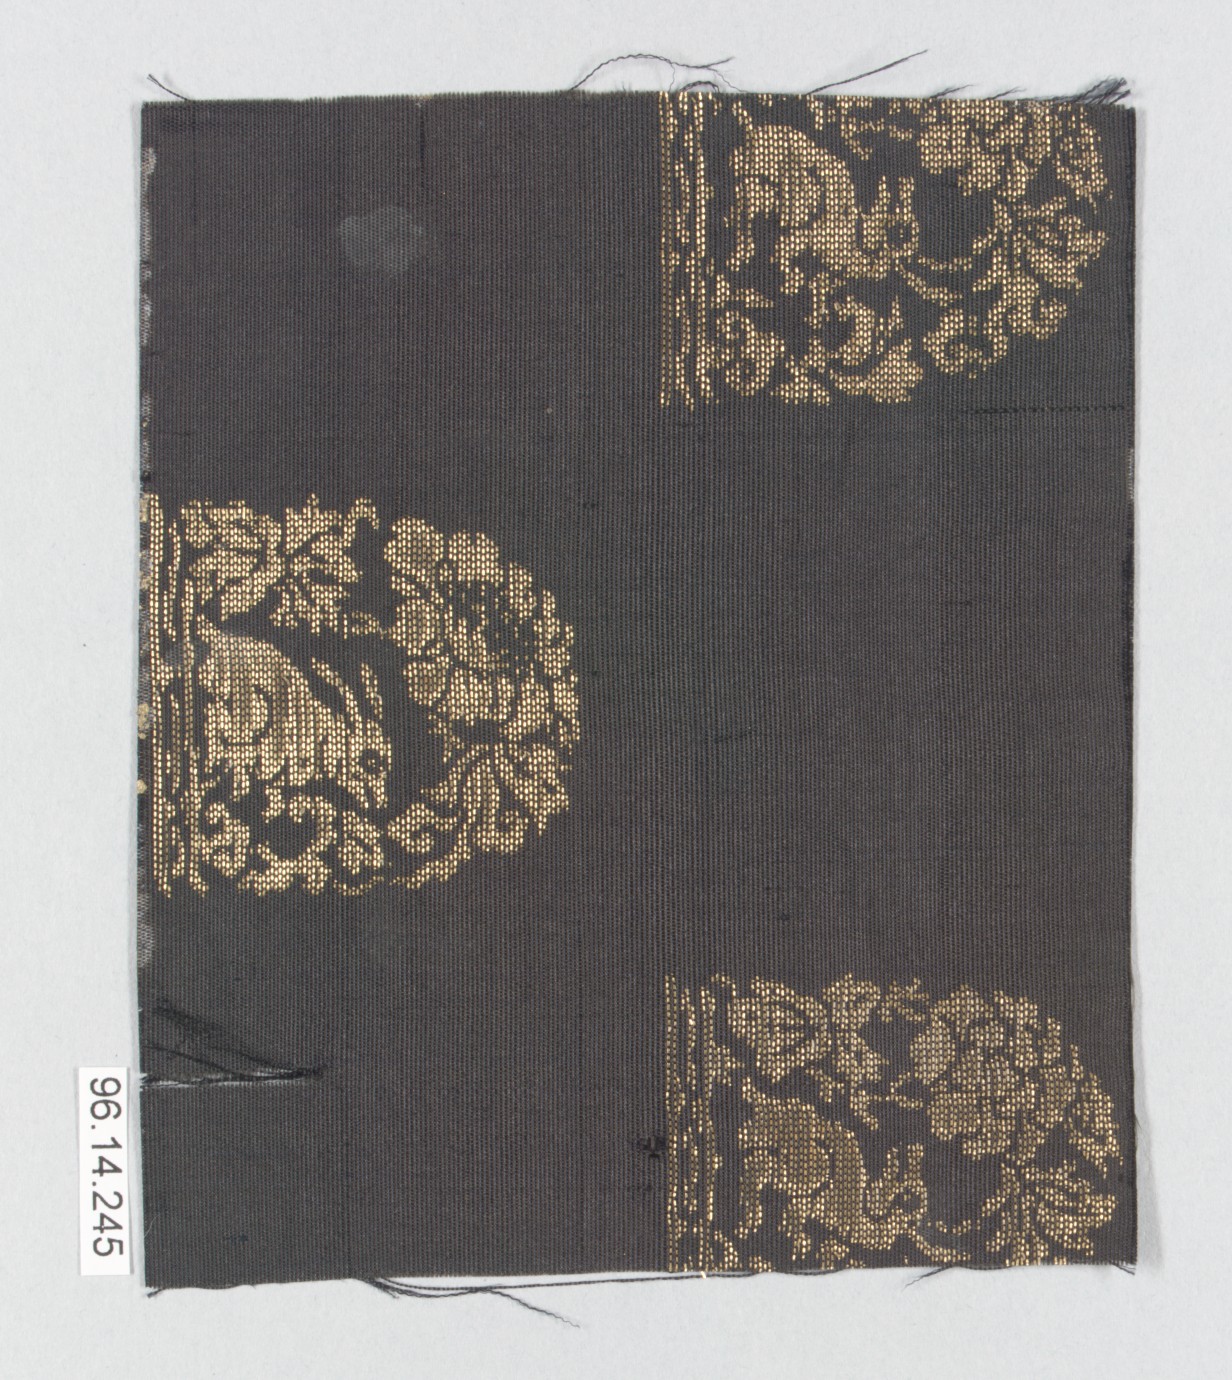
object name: piece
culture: japanese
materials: metal thread, silk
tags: rabbits